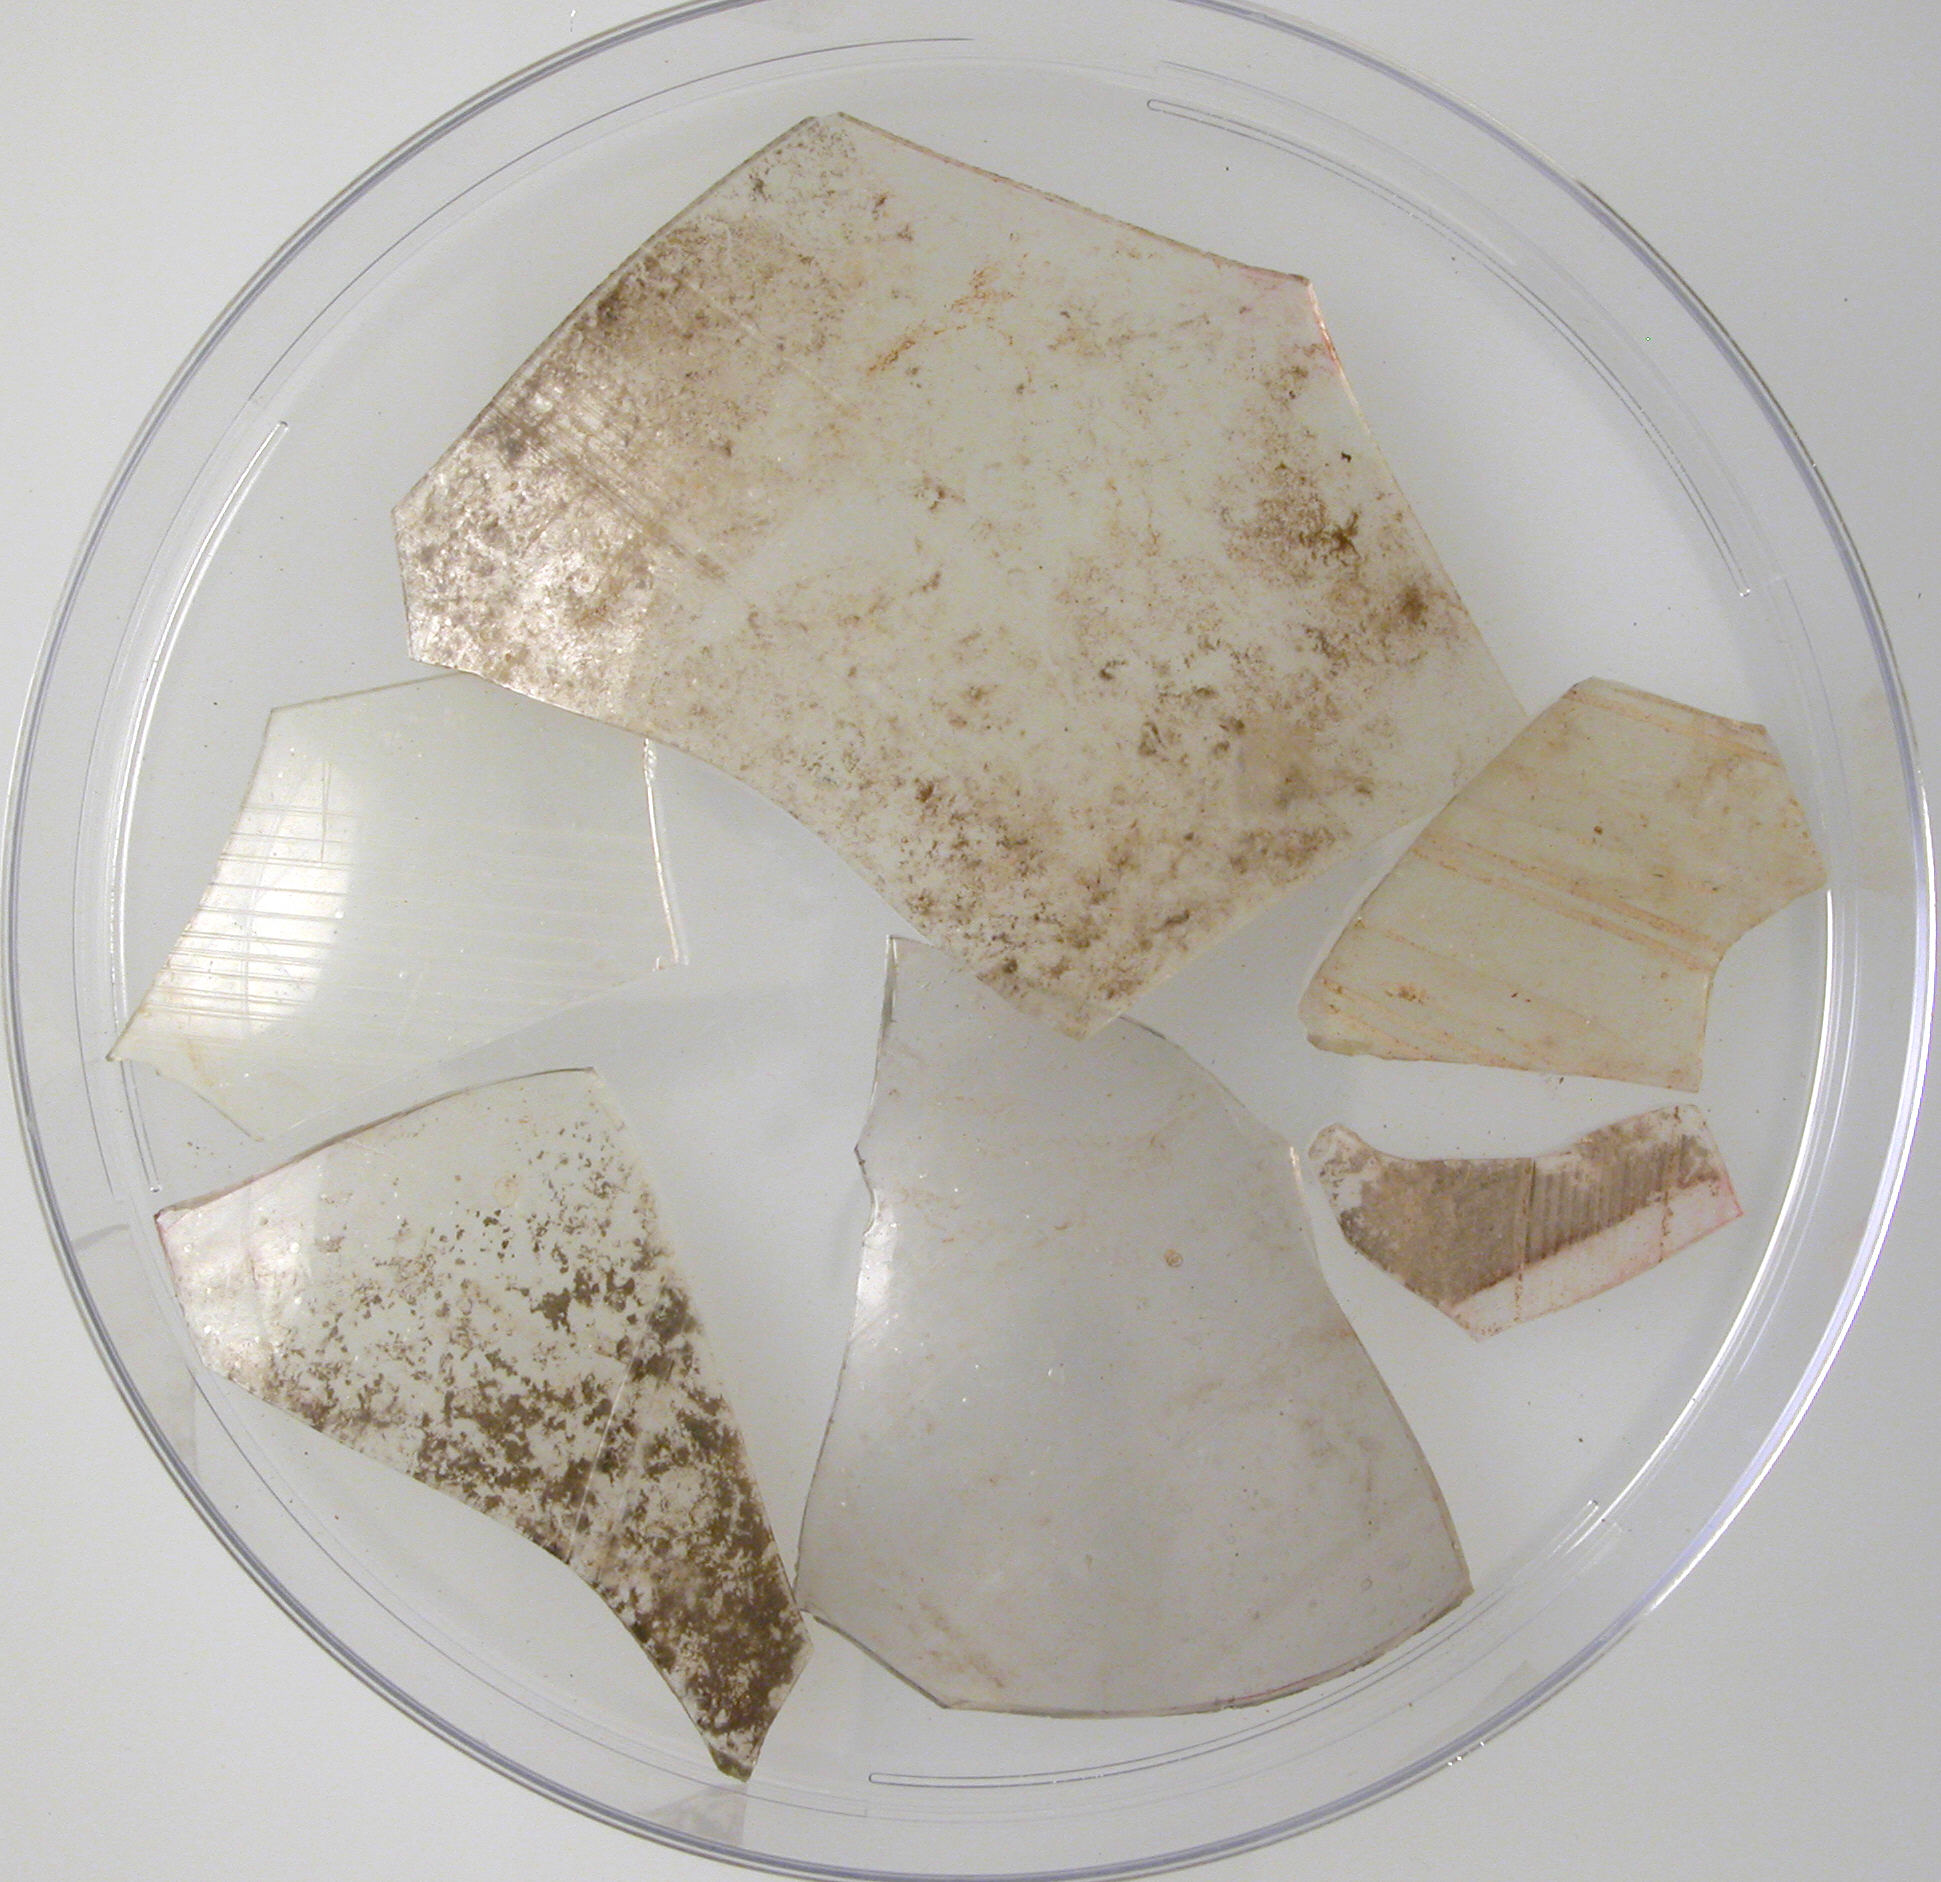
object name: fragment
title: Glass Fragments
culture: coptic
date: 301-433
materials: glass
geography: egypt